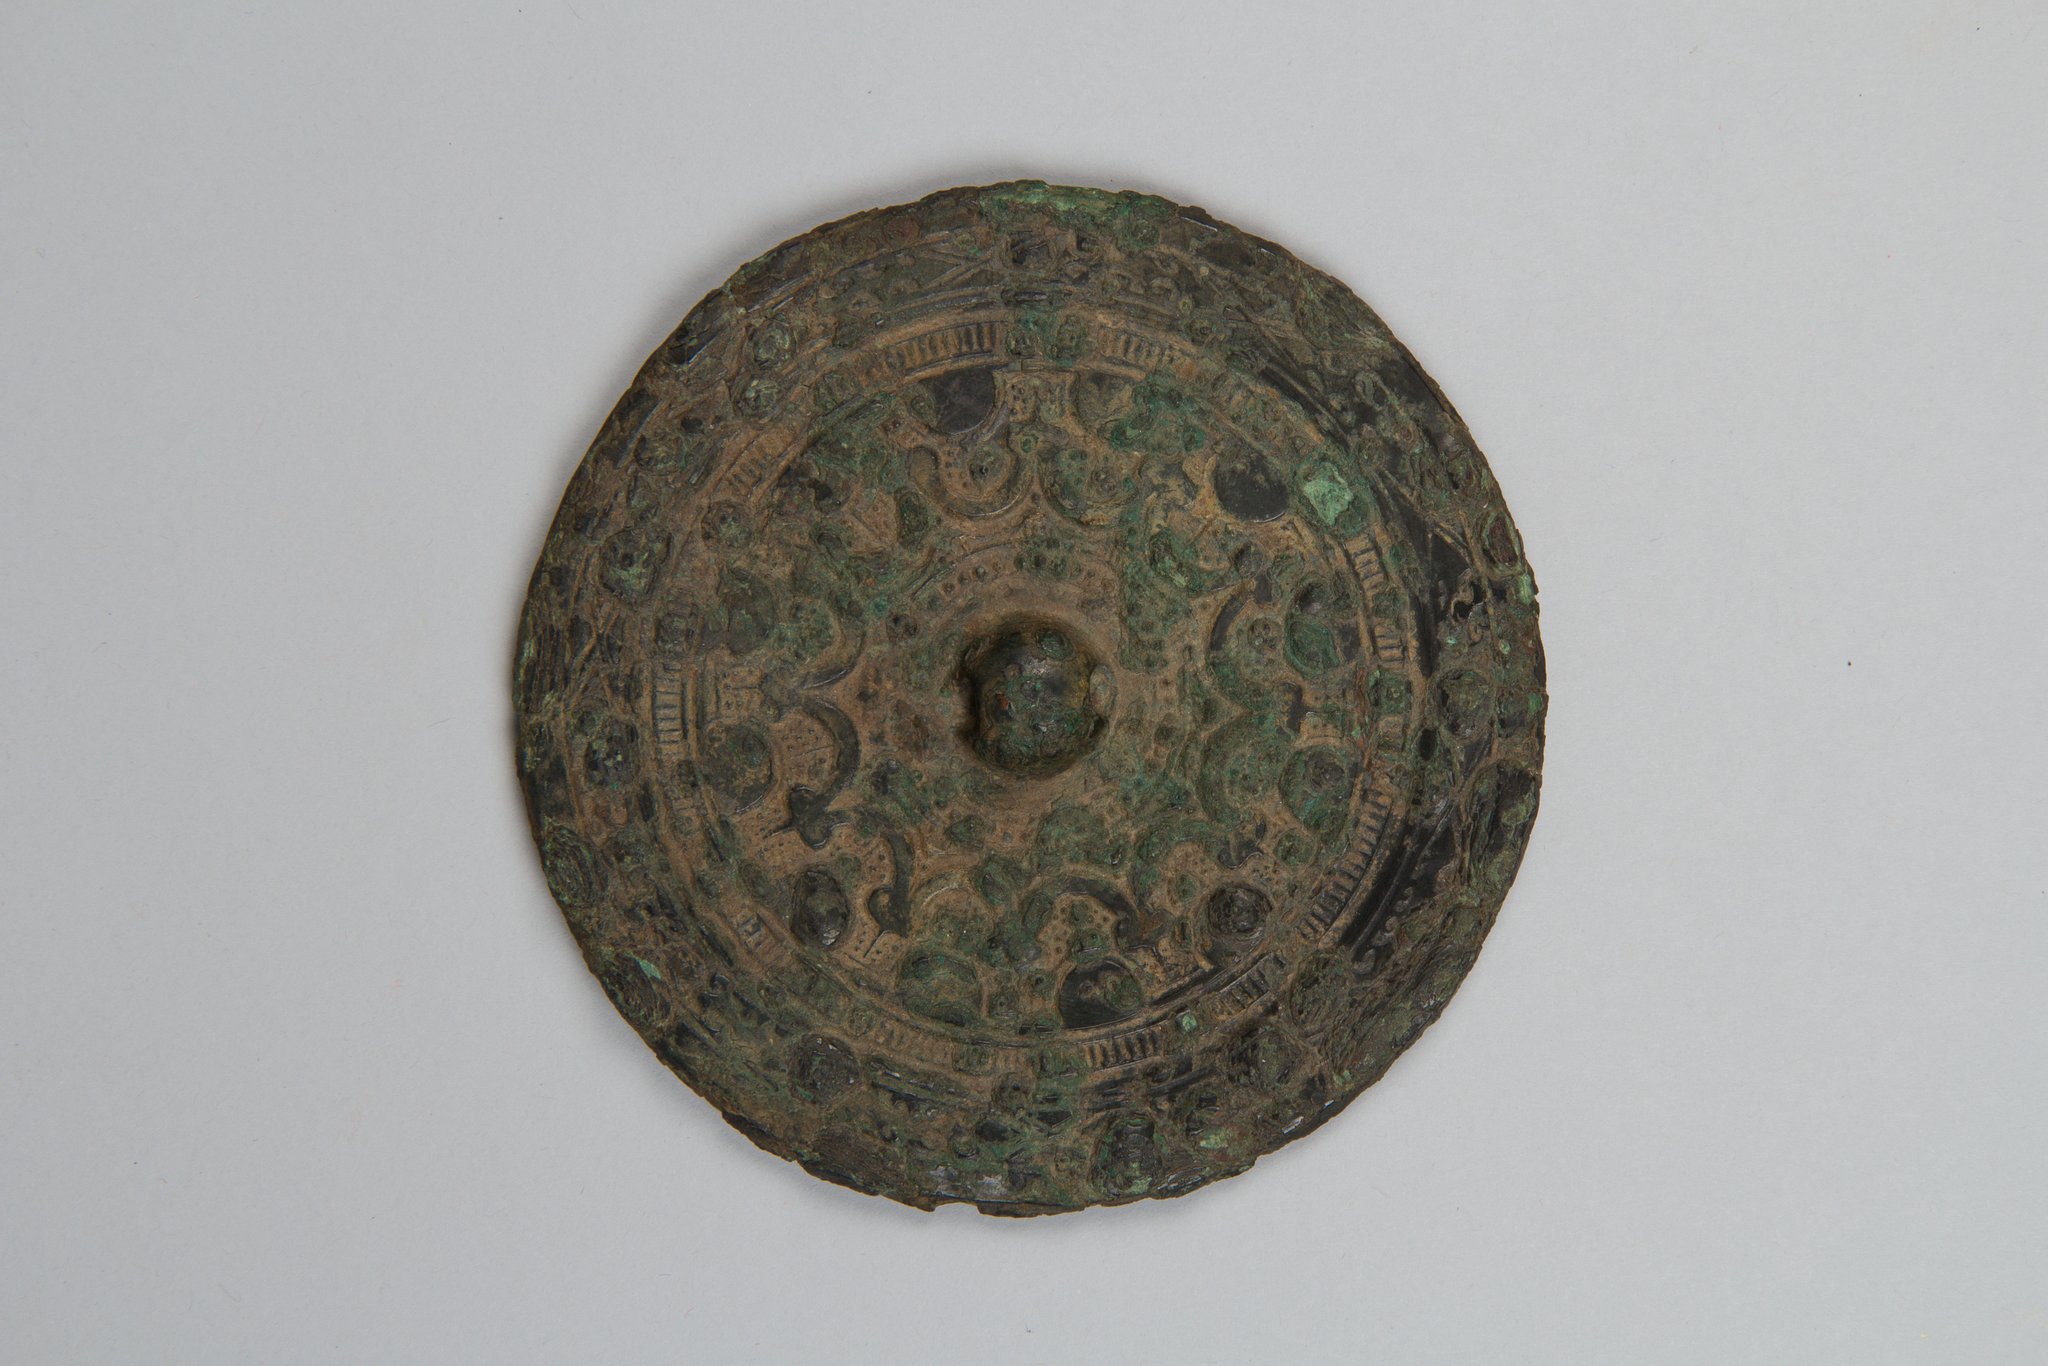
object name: mirror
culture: chinese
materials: bronze